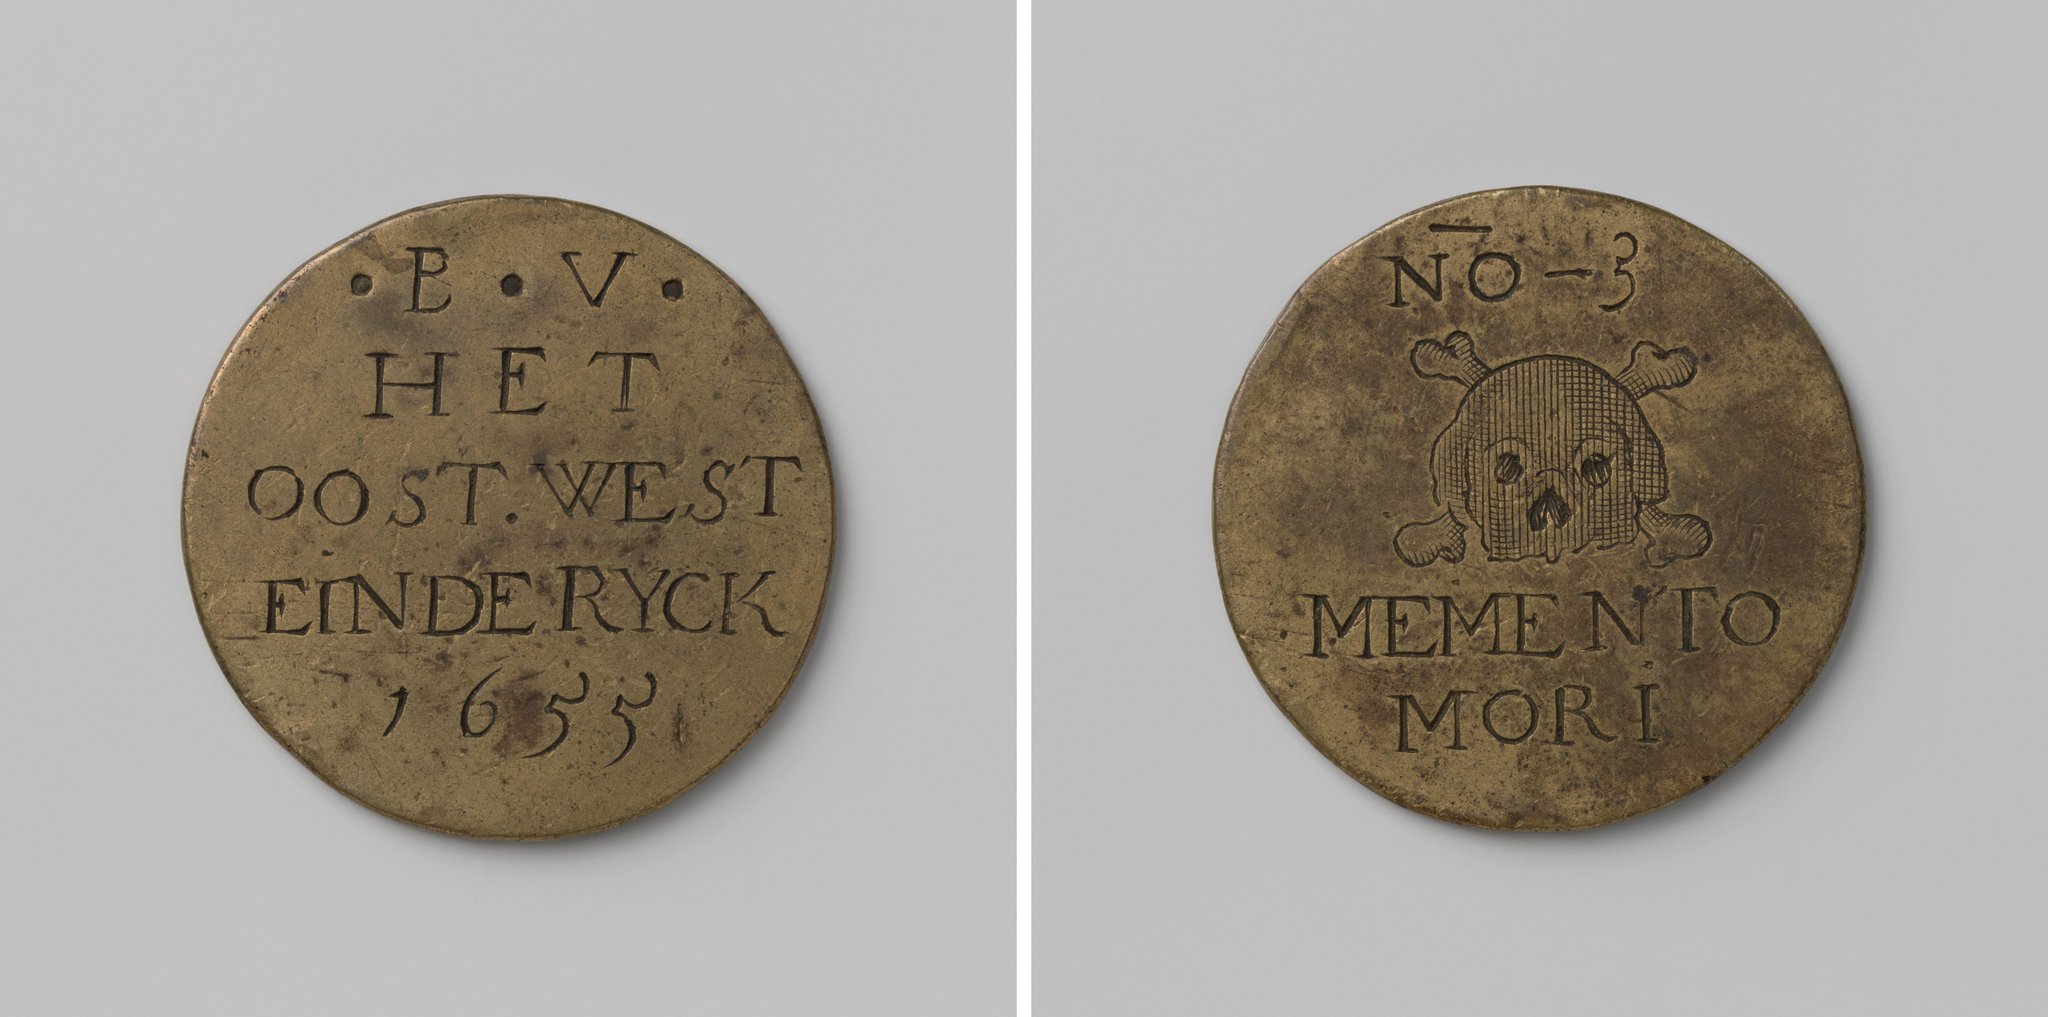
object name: funeral token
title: Buurt van het Oost Westeinde Ryck te 's-Gravenhage, begrafenispenning met no. 3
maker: Anonymous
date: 1655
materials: brass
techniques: engraving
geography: the hague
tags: the hague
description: Messing penning. Voorzijde: opschrift boven jaartal. Keerzijde: doodshoofd op twee gekruiste beenderen onder cijfer no. 3 boven opschrift